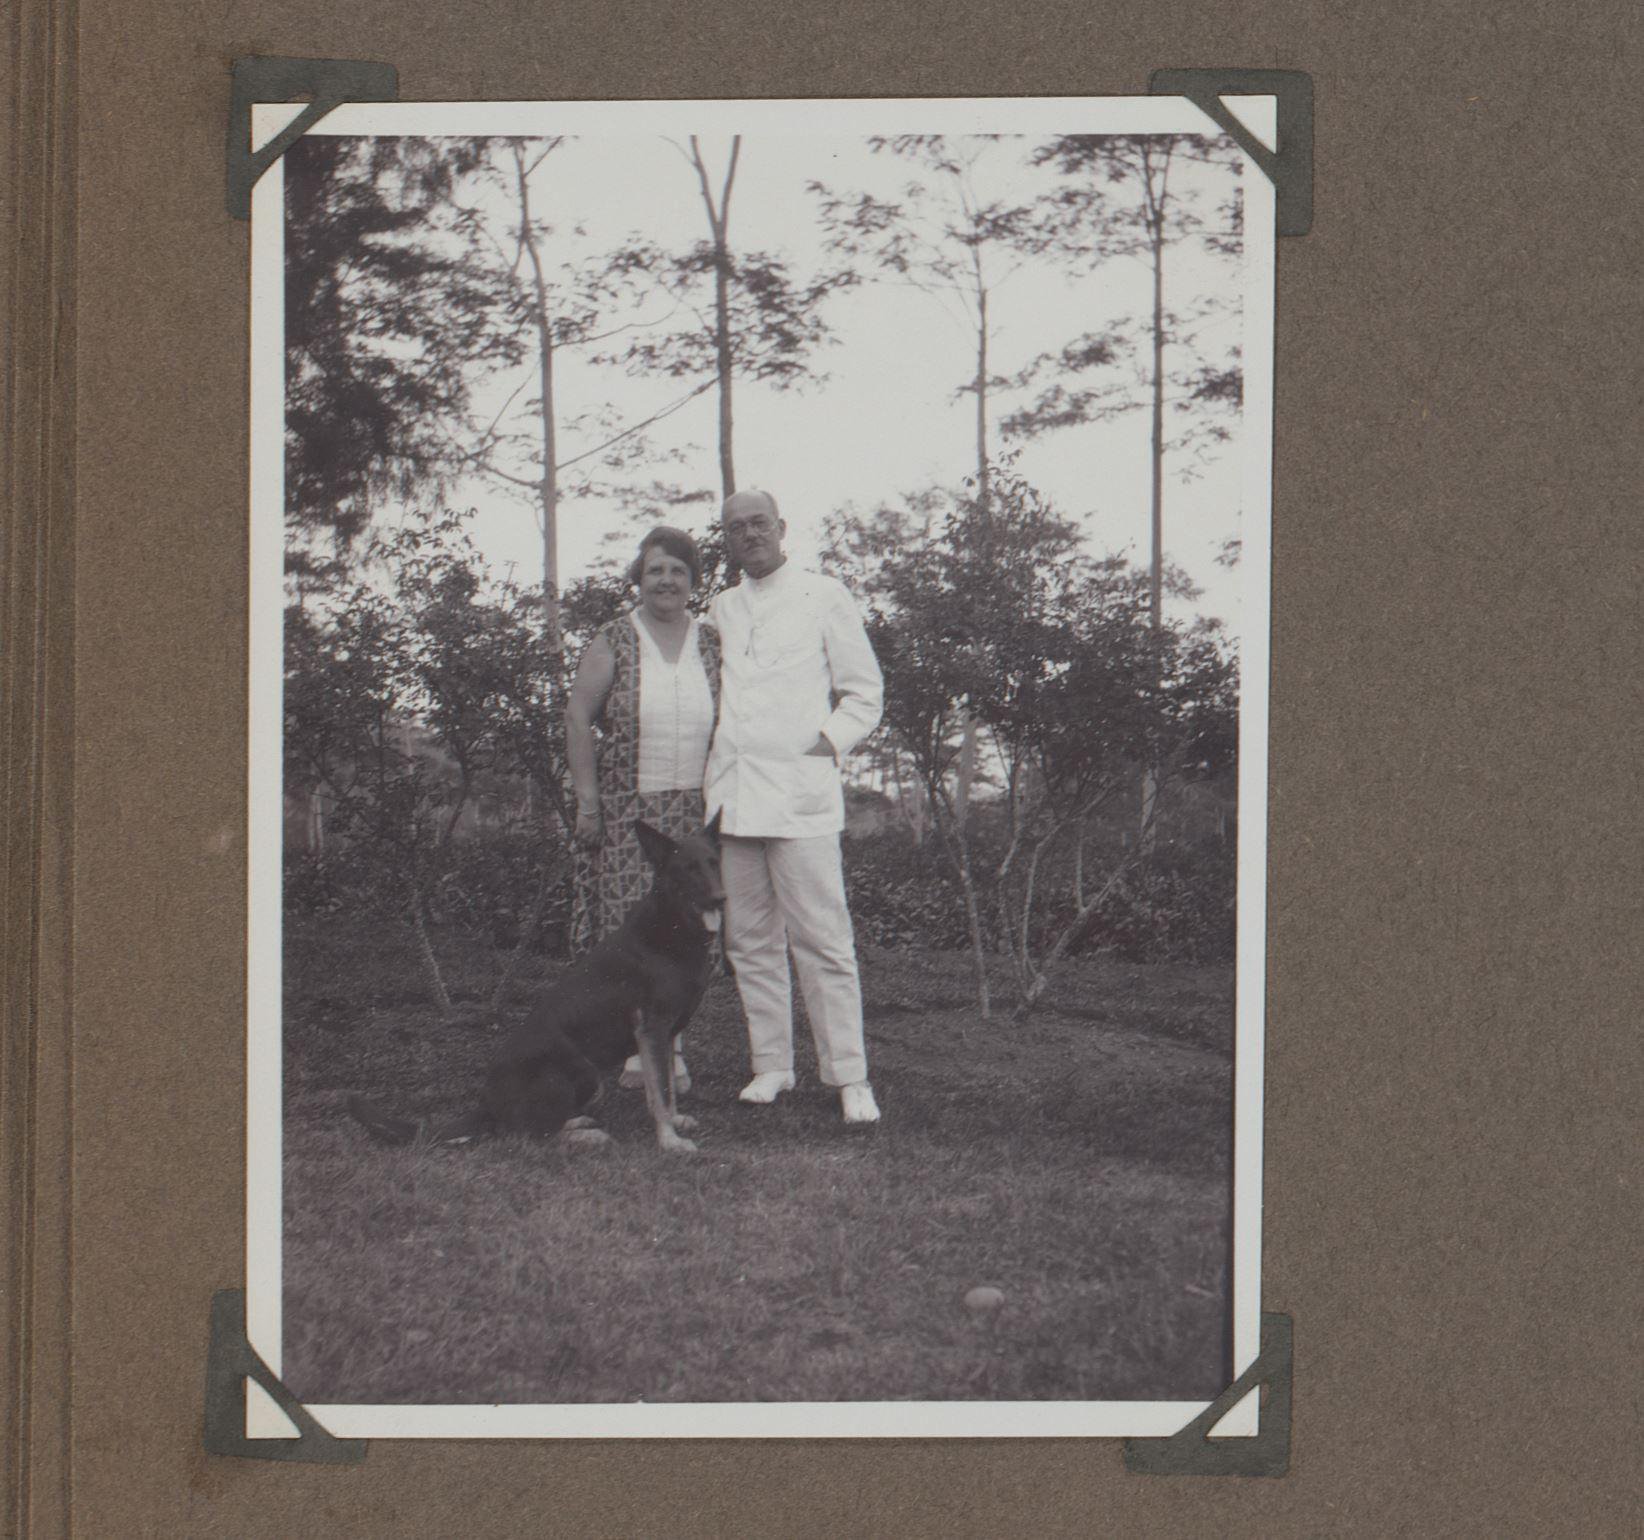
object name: album leaf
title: Man en vrouw met herdershond in een tuin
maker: Anonymous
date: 1930-1935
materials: paper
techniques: gelatin silver print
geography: dutch east indies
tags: adult woman, adult man, dog, dutch east indies, the